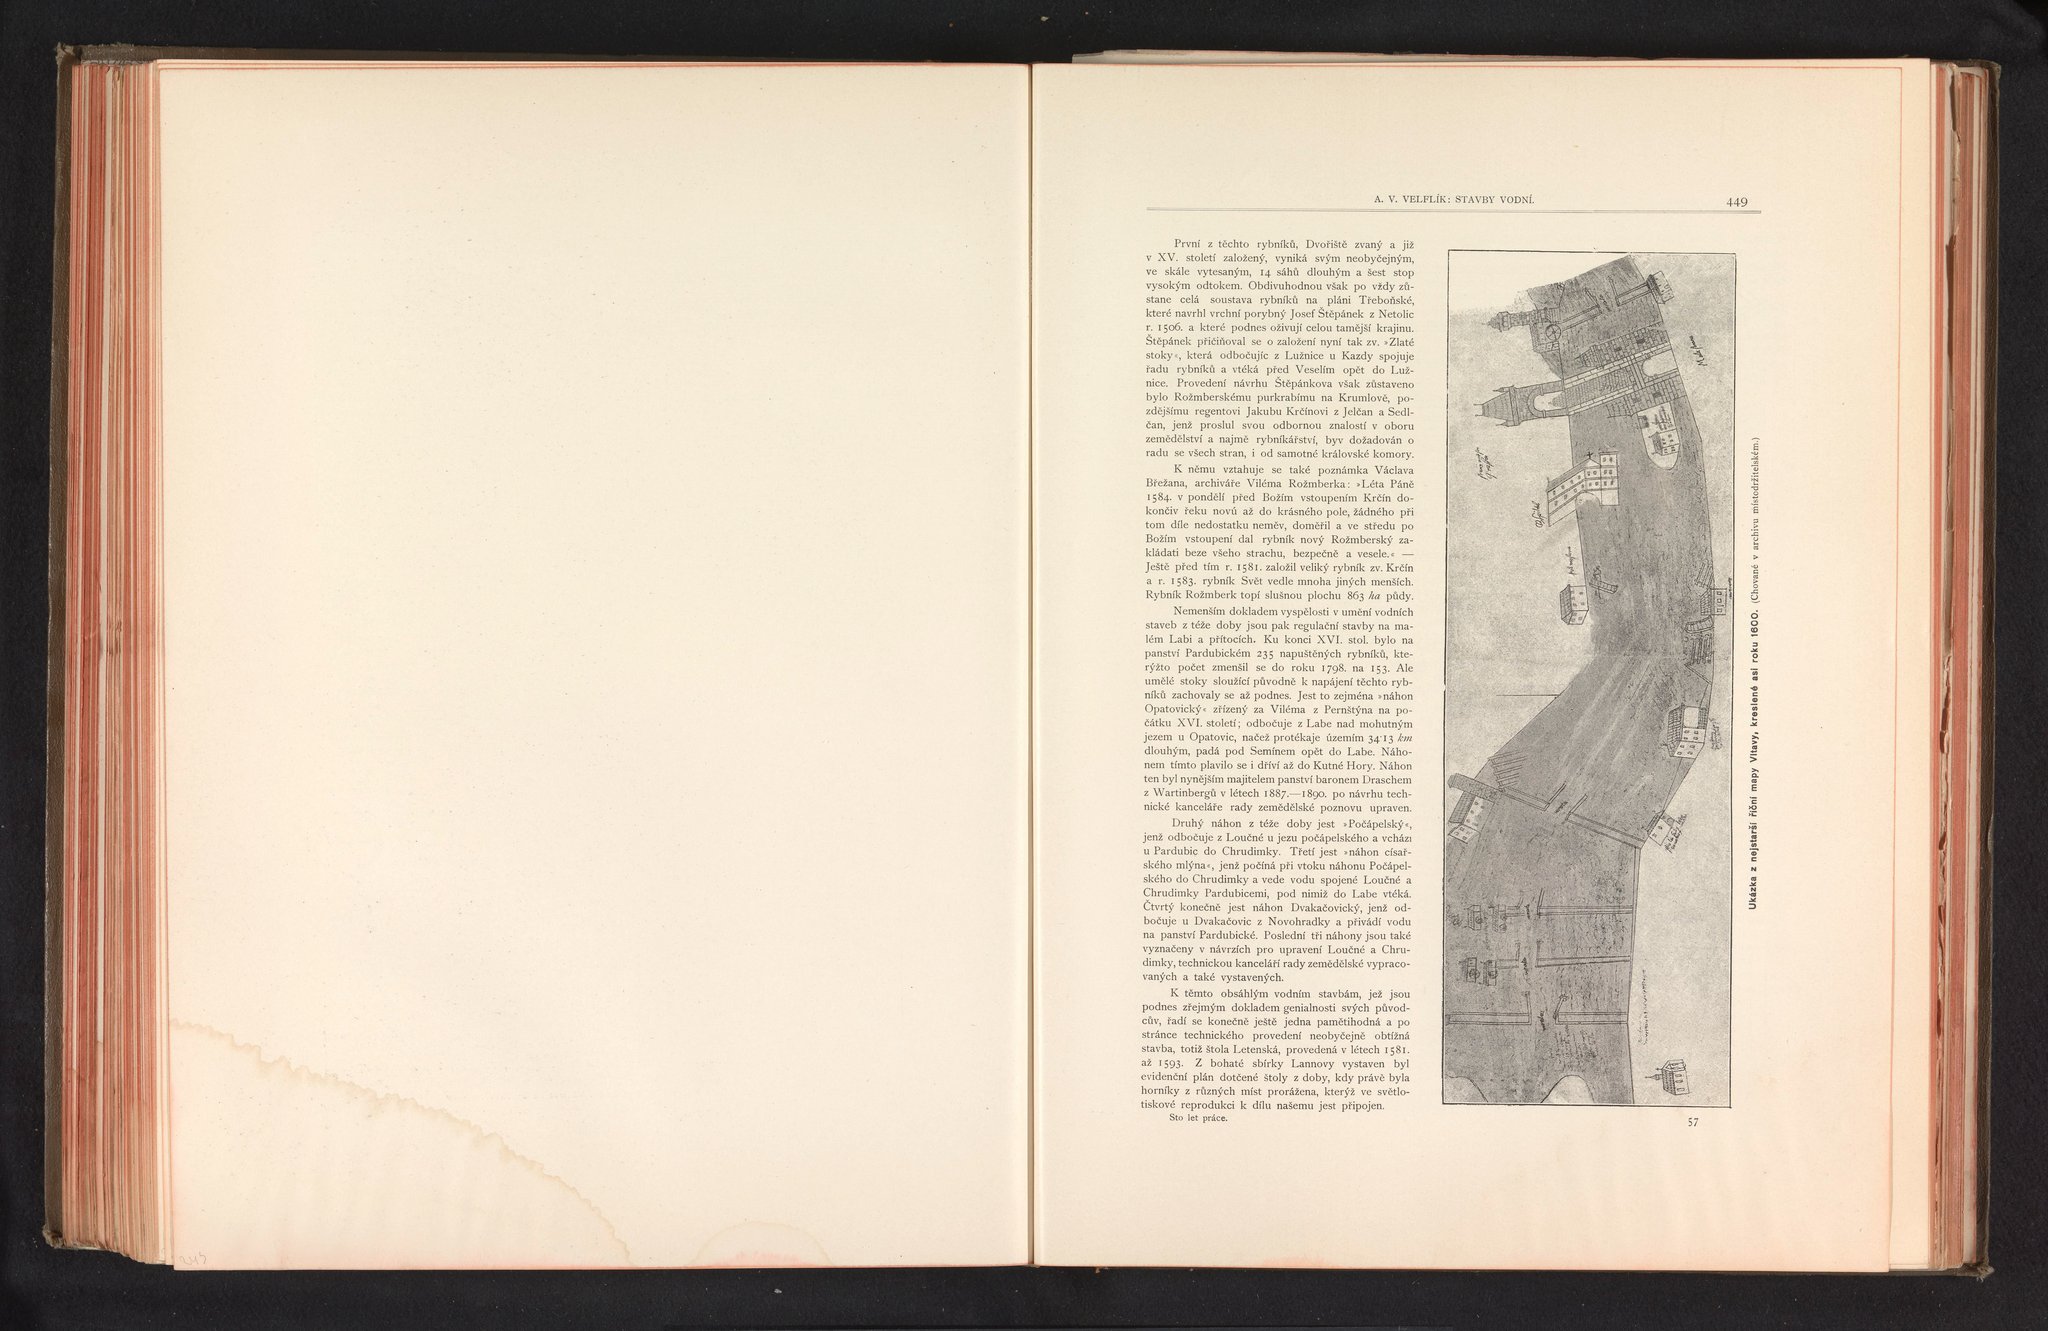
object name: photomechanical print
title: Fotoreproductie van een prent, voorstellende een kaart van de Moldau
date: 1891-1895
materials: paper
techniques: autotype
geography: prague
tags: river, maps, atlases